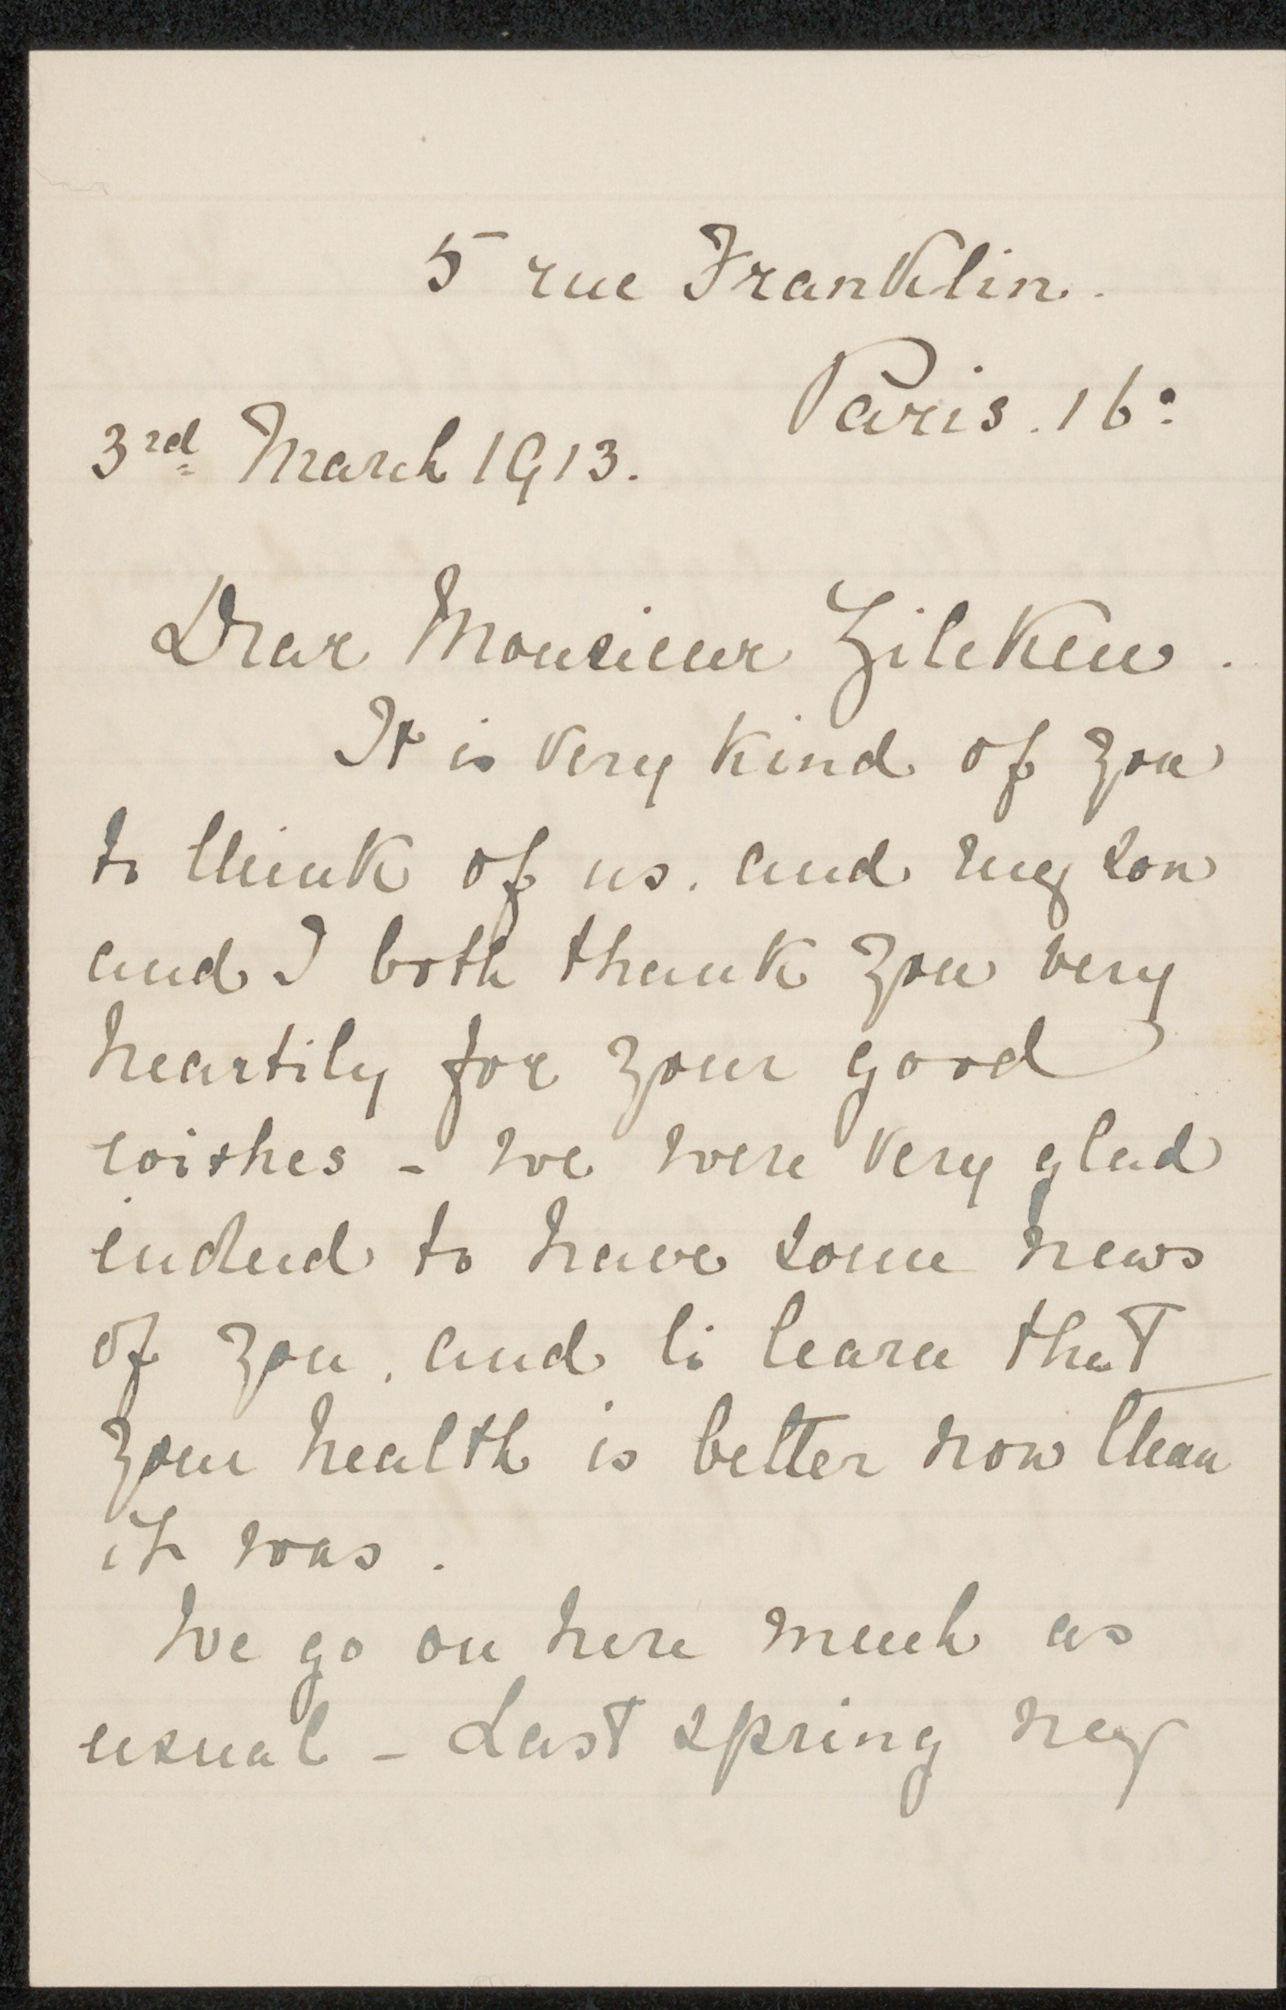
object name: letter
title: Brief aan Philip Zilcken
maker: henrietta buhot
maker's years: -1913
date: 1913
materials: ink, paper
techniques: pen, writing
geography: paris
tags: the hague, painter, draughtsman, philip zilcken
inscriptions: collector's mark: ‘RPK’